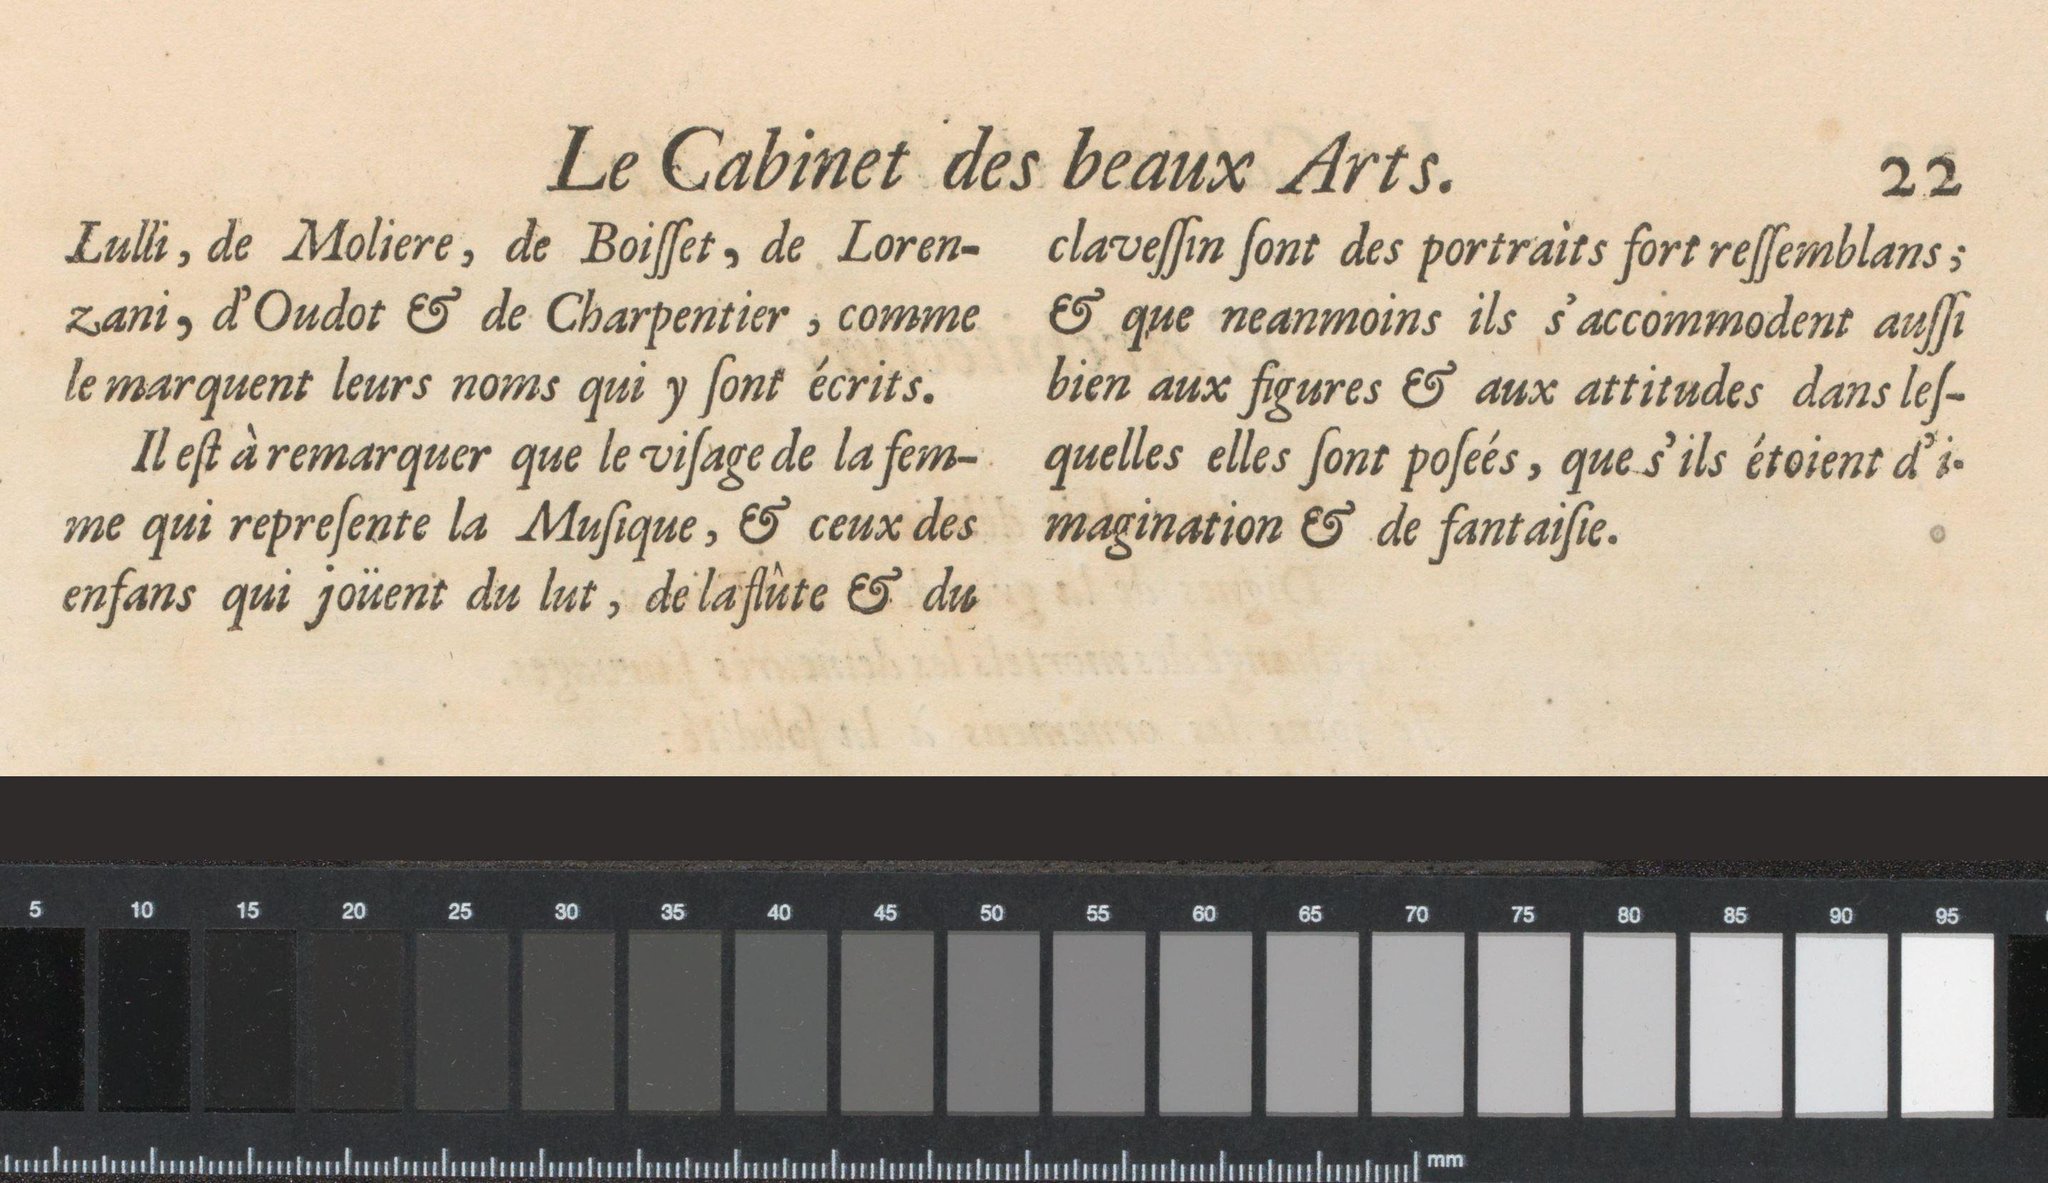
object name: text sheet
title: Tekstblad met verklaring van de prent over Muziek, p. 22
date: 1695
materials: paper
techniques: letterpress printing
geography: paris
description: Verklaring van de prent met voorstelling van Muziek in het Frans. Pagina 22. Tekstblad maakt deel uit van een album.